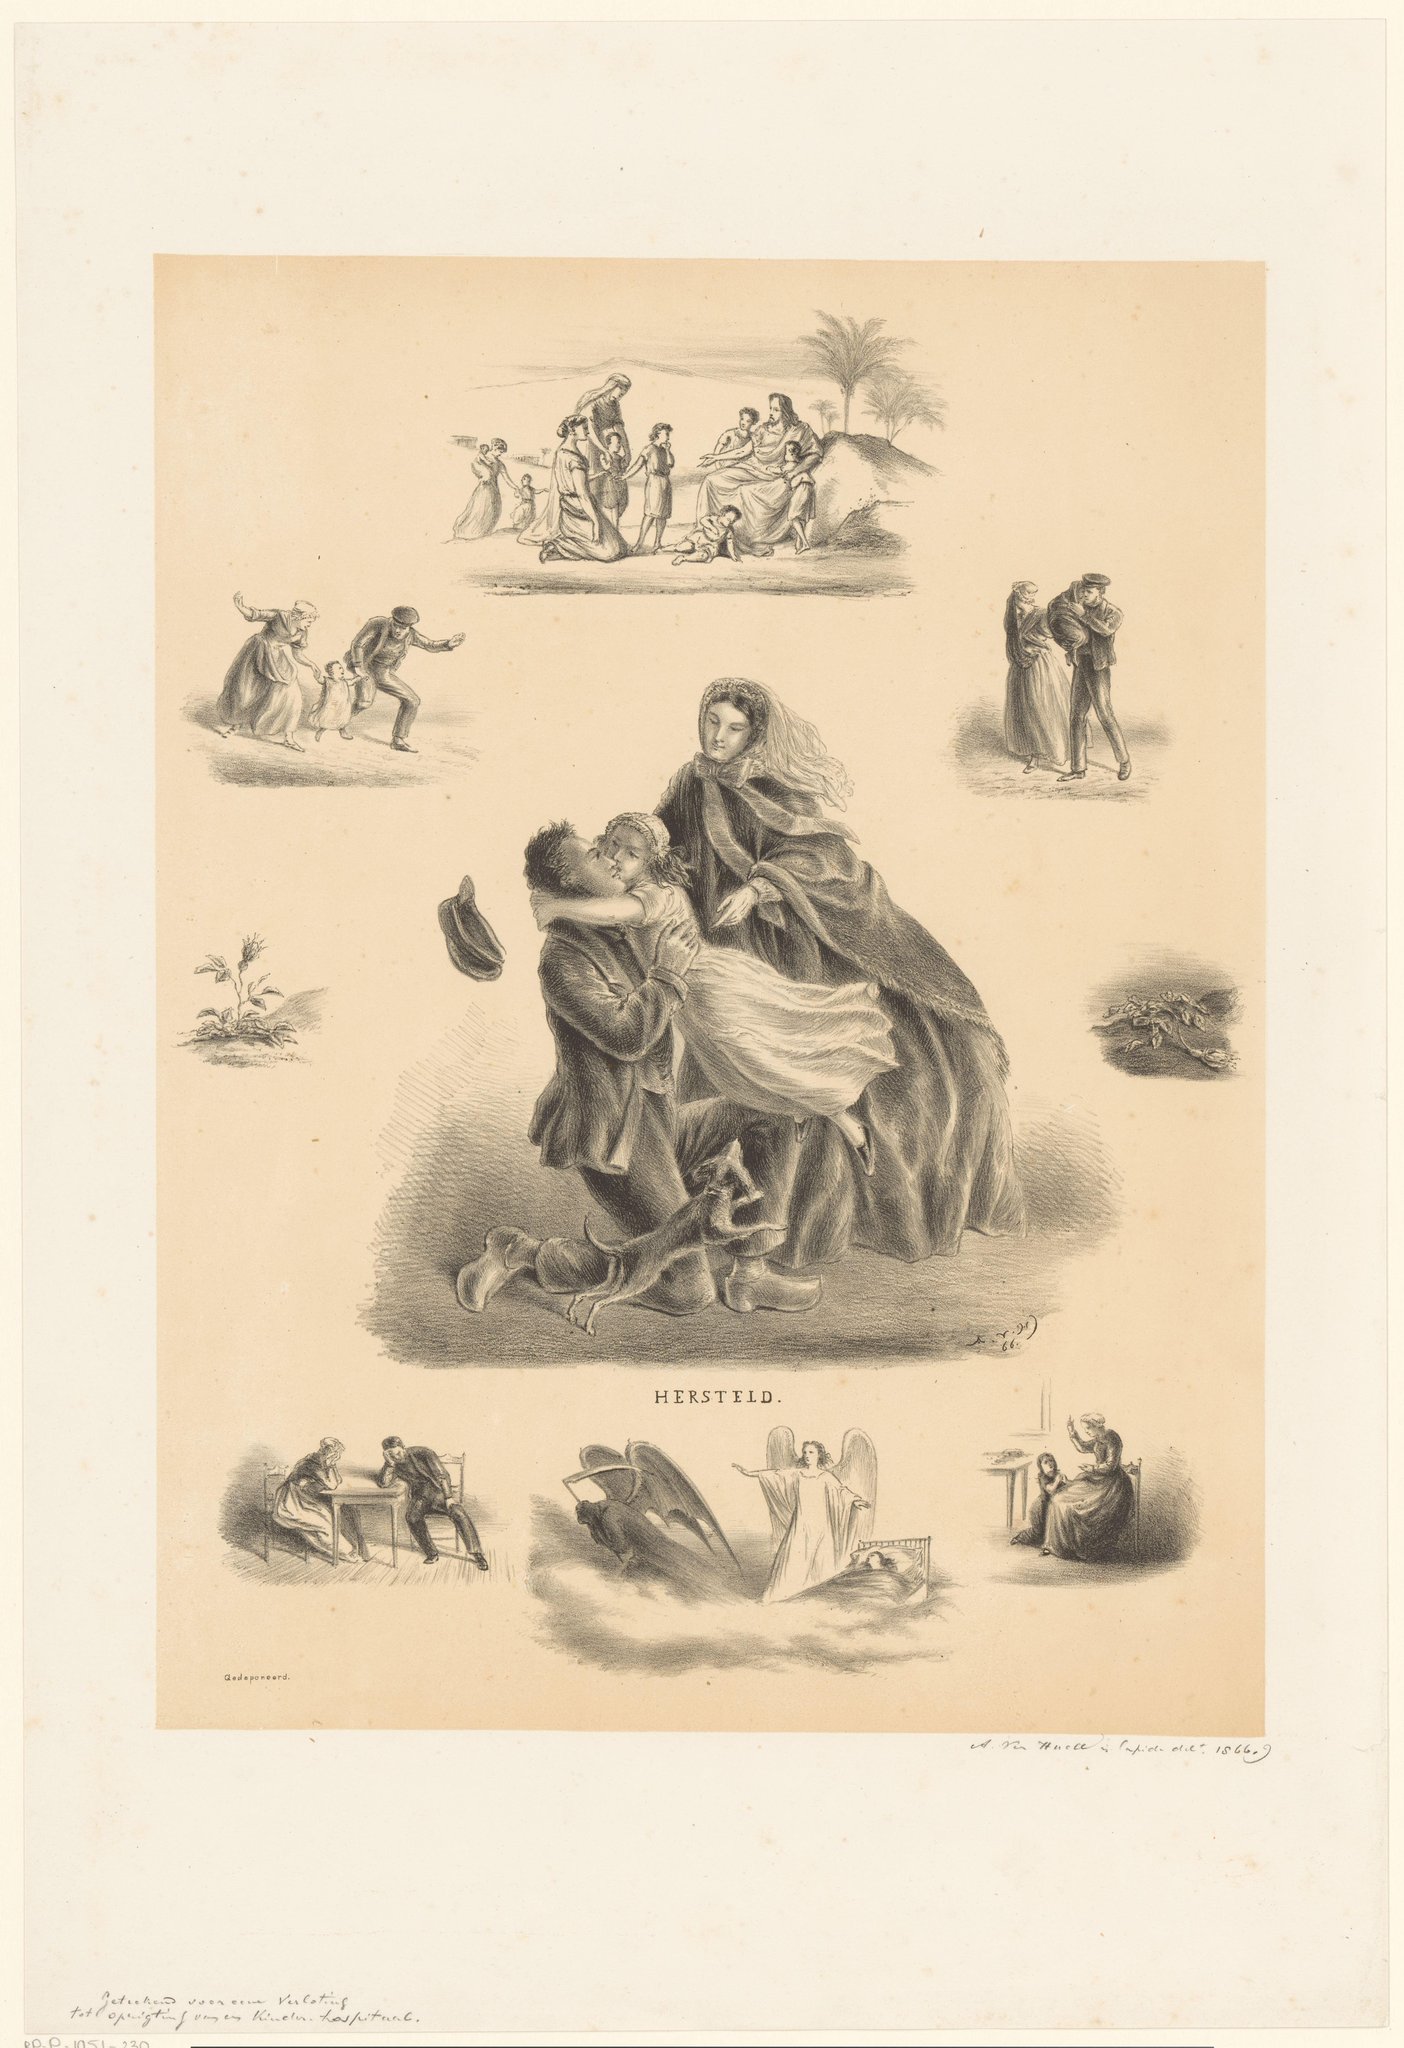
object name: print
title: Kind en vrouw vliegen man om zijn nek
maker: alexander ver huell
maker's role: draughtsman, print maker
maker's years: 1822-1897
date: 1866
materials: paper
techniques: tone lithography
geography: netherlands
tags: recovery, convalescence of sick person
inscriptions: inscription: ‘Geteekend voor eene Verloting tot oprigting van een Kinder hospitaal’, : ‘Gedeponeerd.’, collector's mark: Lugt 2228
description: Een man wordt omhelsd door zijn kind en vrouw na zijn herstel van het ziekbed. Rondom zes voorstellingen te maken met ziekte en herstel.